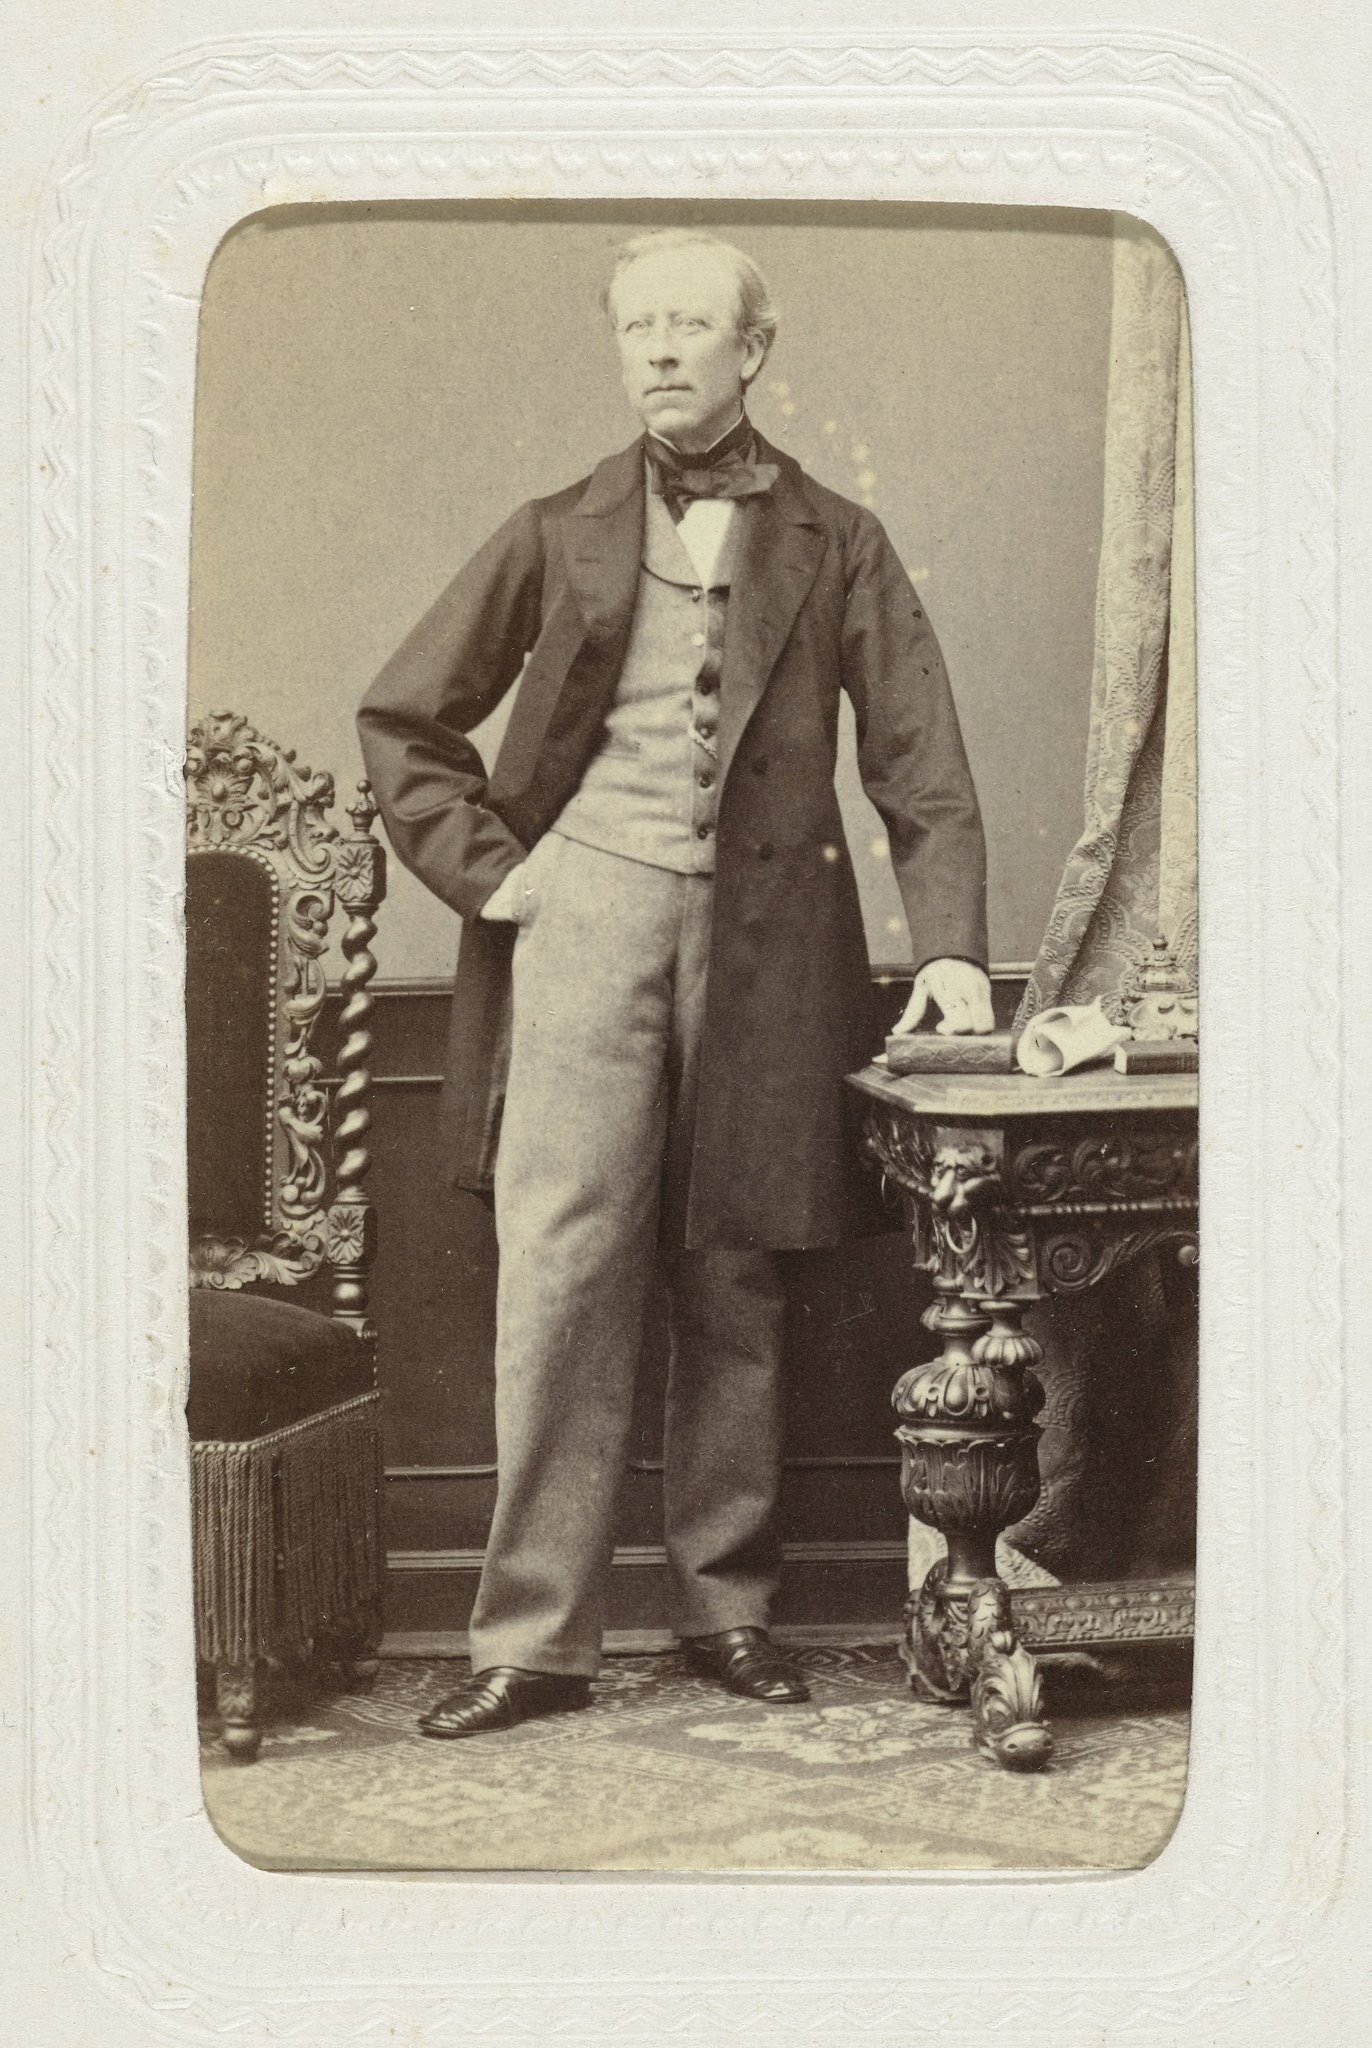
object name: carte de visite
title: Studioportret van een man poserend bij een tafel met een hand in de broekzak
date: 1863-1866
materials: cardboard, paper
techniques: albumen print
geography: istanbul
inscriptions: name: ‘Abdullah freres, Constantinople’, name: ‘Dixon’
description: De afgebeelde man is vermoedelijk de heer Dixon